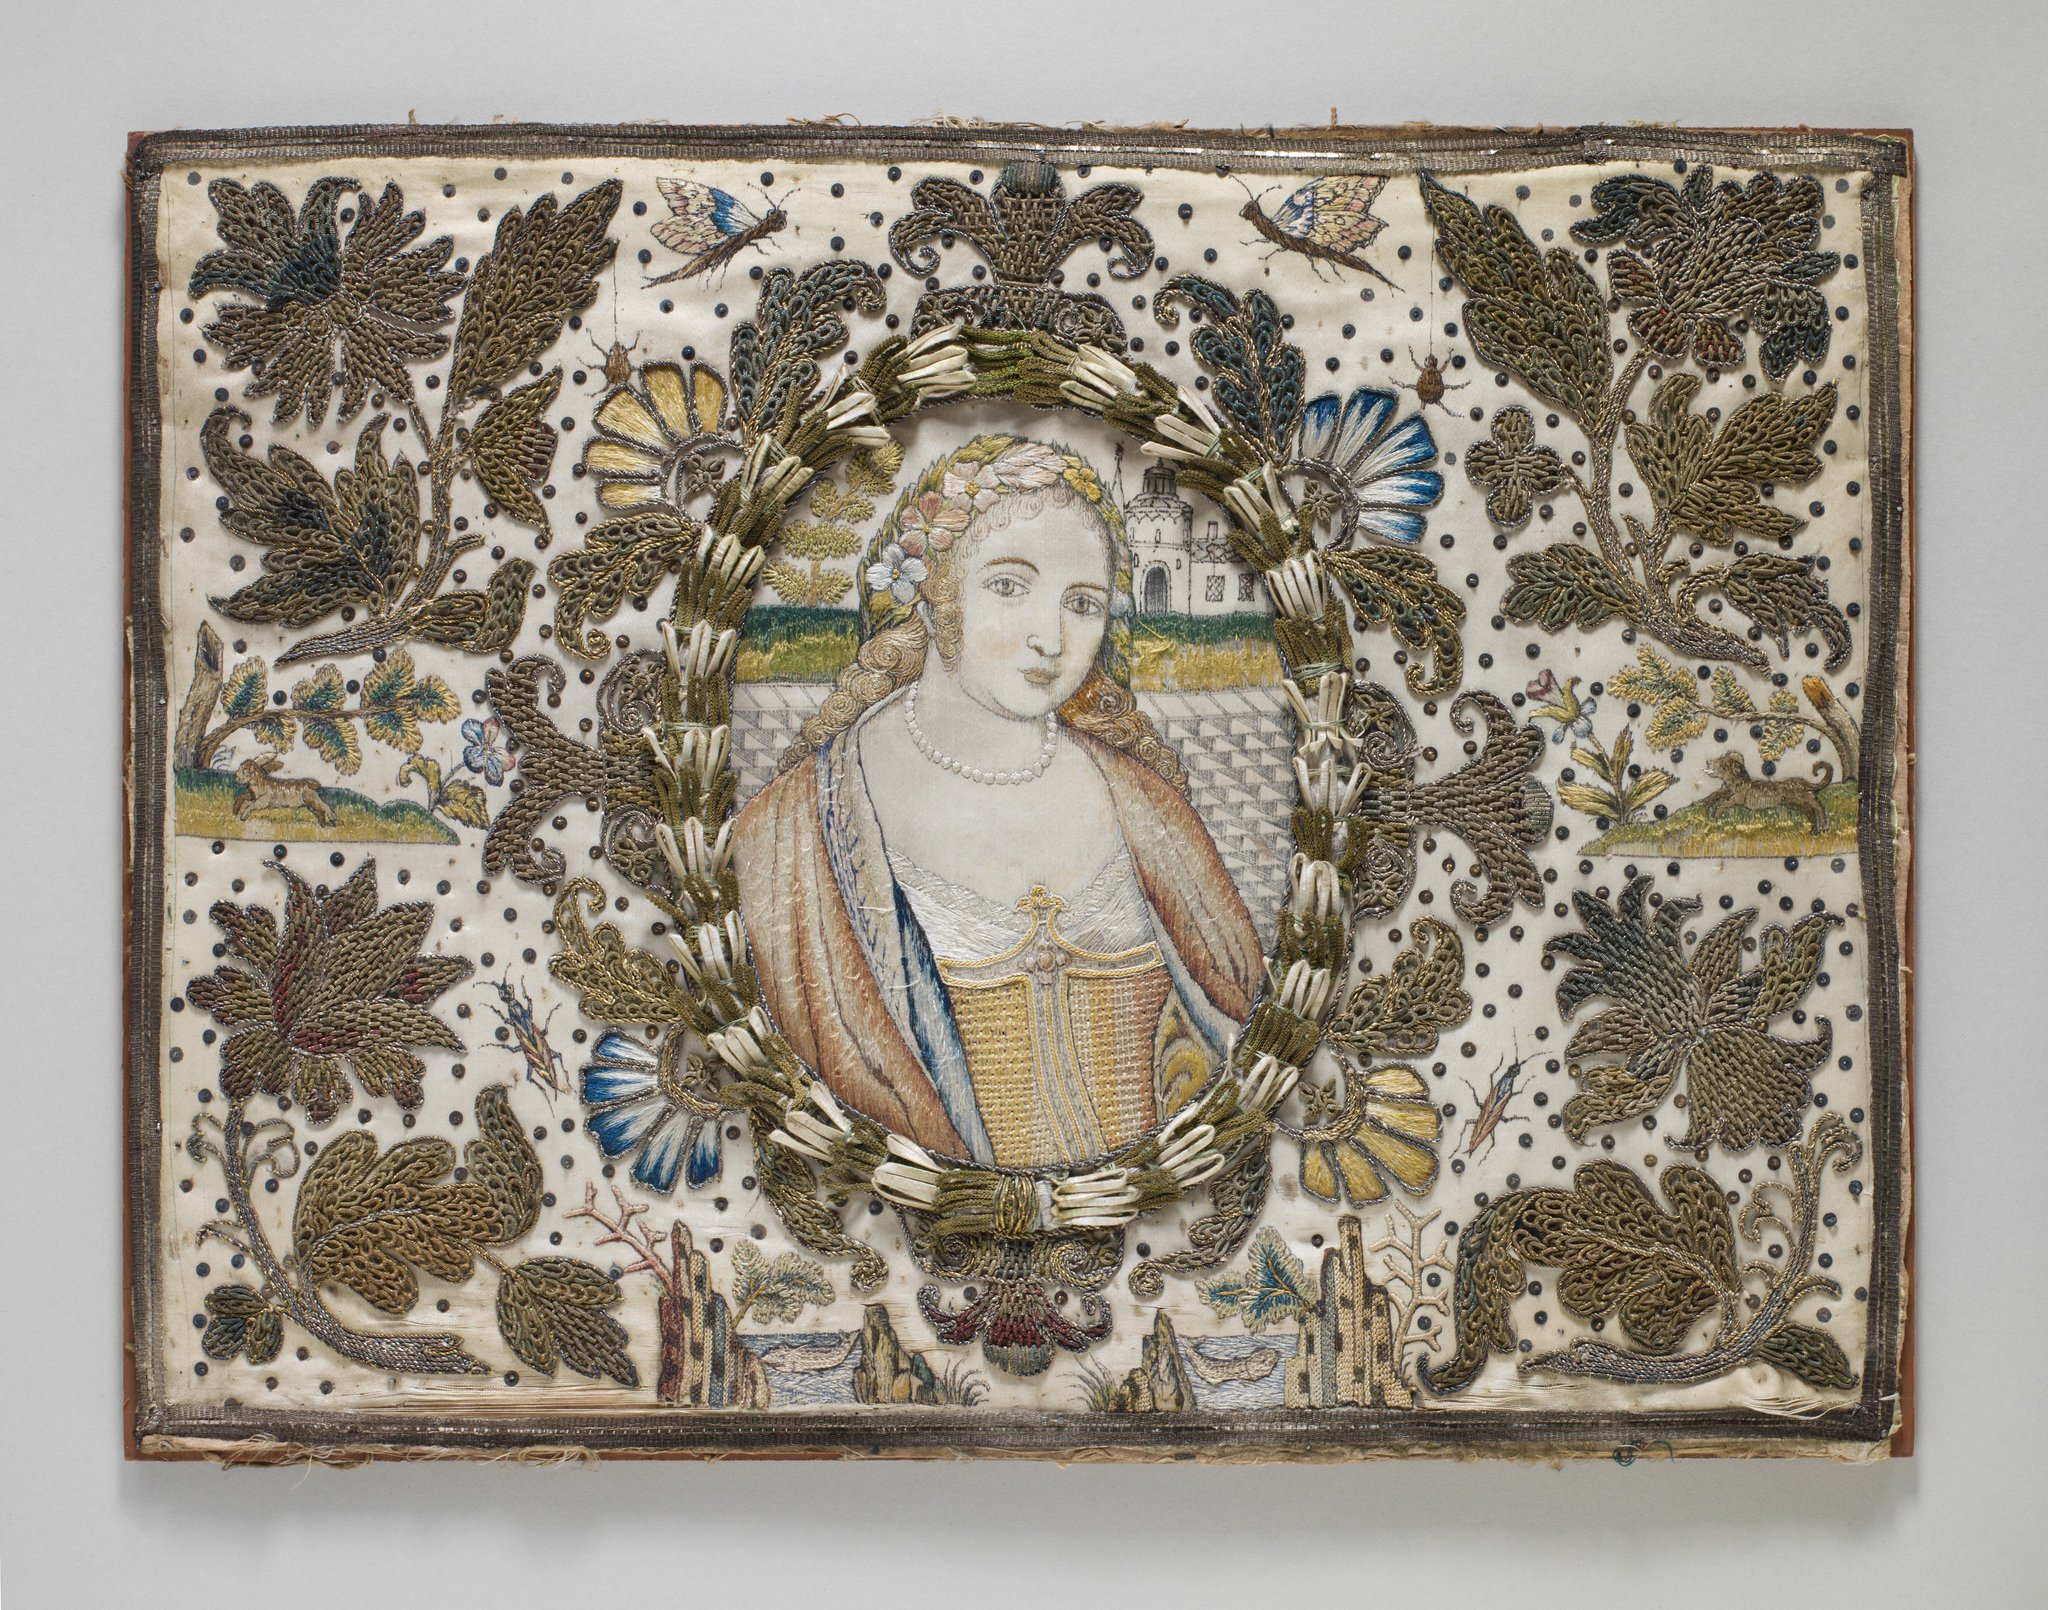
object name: cabinet panel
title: A Lady, said to be Elizabeth Coombe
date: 1651-1675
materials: metal thread, textile, silk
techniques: embroidery, stitching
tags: portraits,women,insects,butterflies